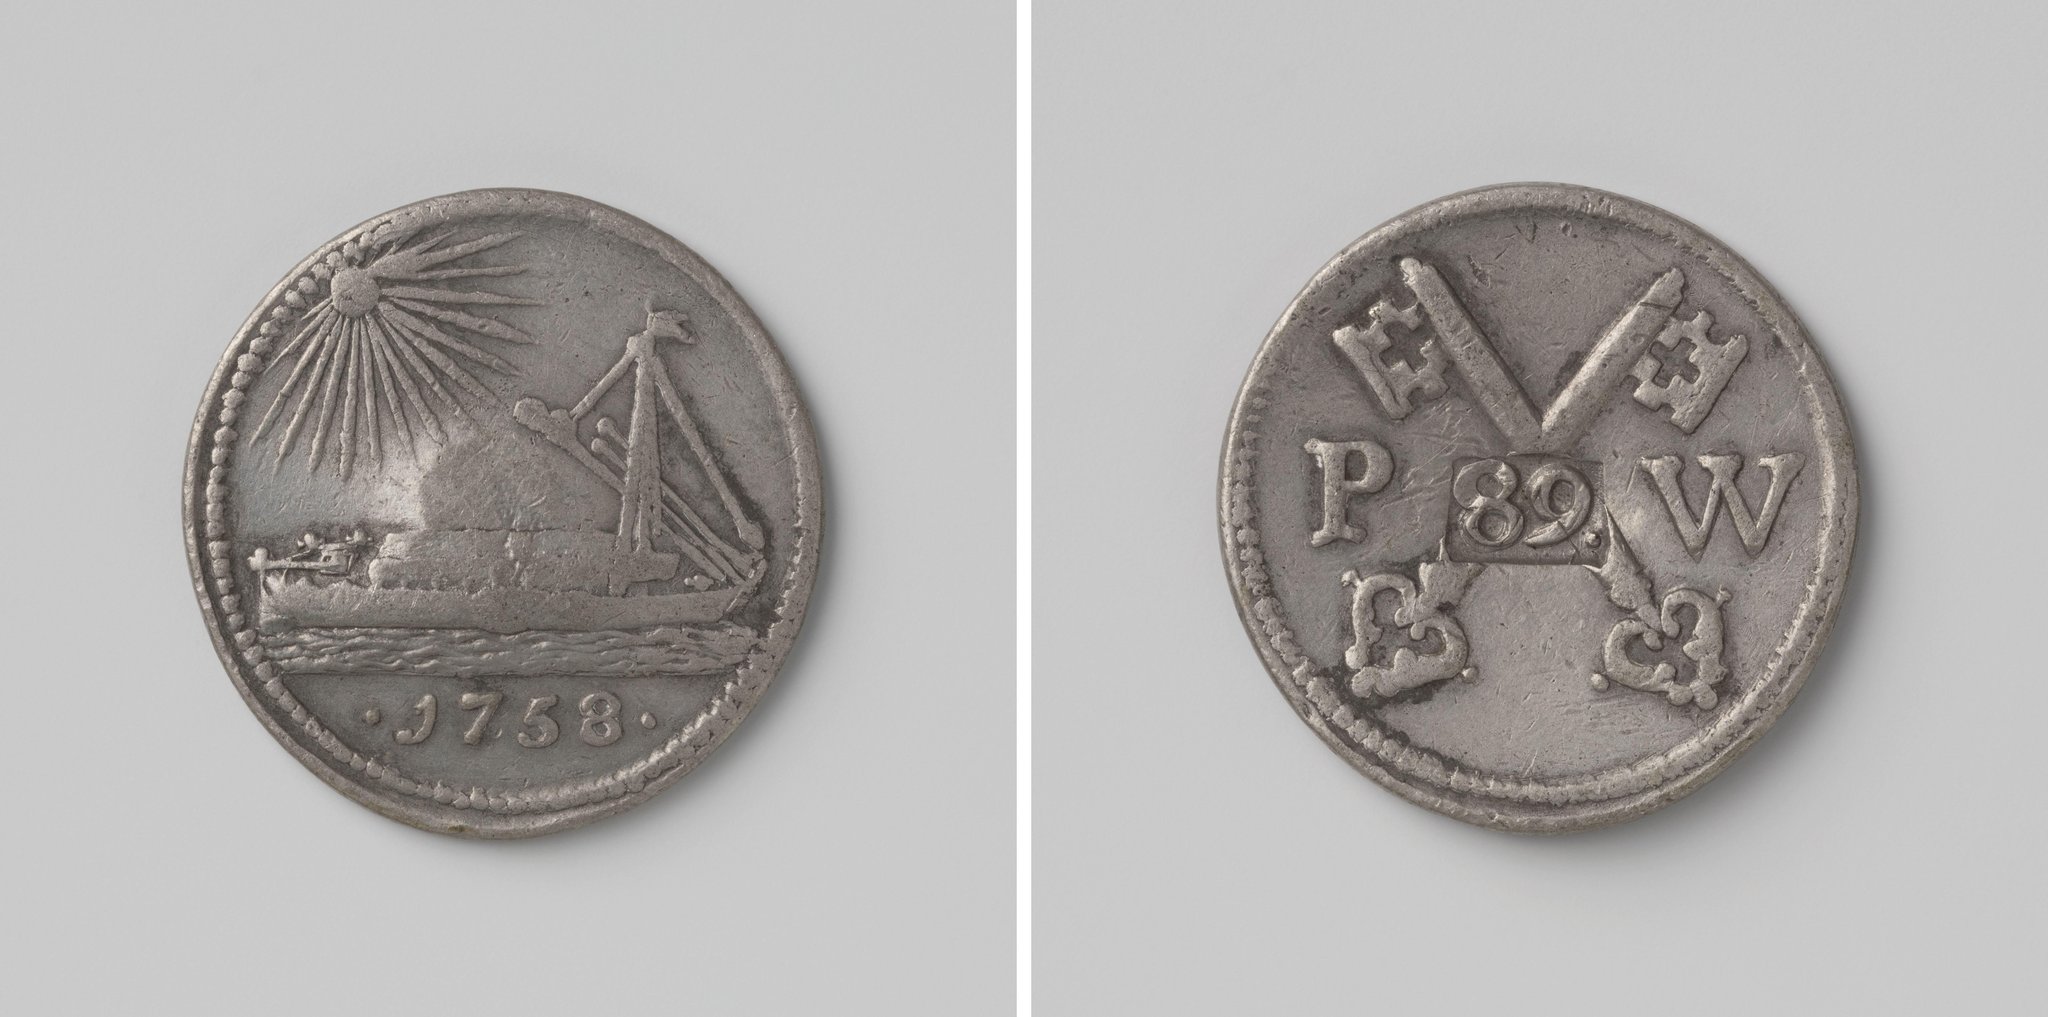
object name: armenloodje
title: Waalse gemeente van Leiden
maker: Anonymous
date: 1758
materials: lead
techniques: striking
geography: leiden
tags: leiden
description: Loden penning. Voorzijde: naar rechts varend schip, beschenen door zon; afsnede: jaartal. Keerzijde: twee gekruiste sleutels tussen letters P en W